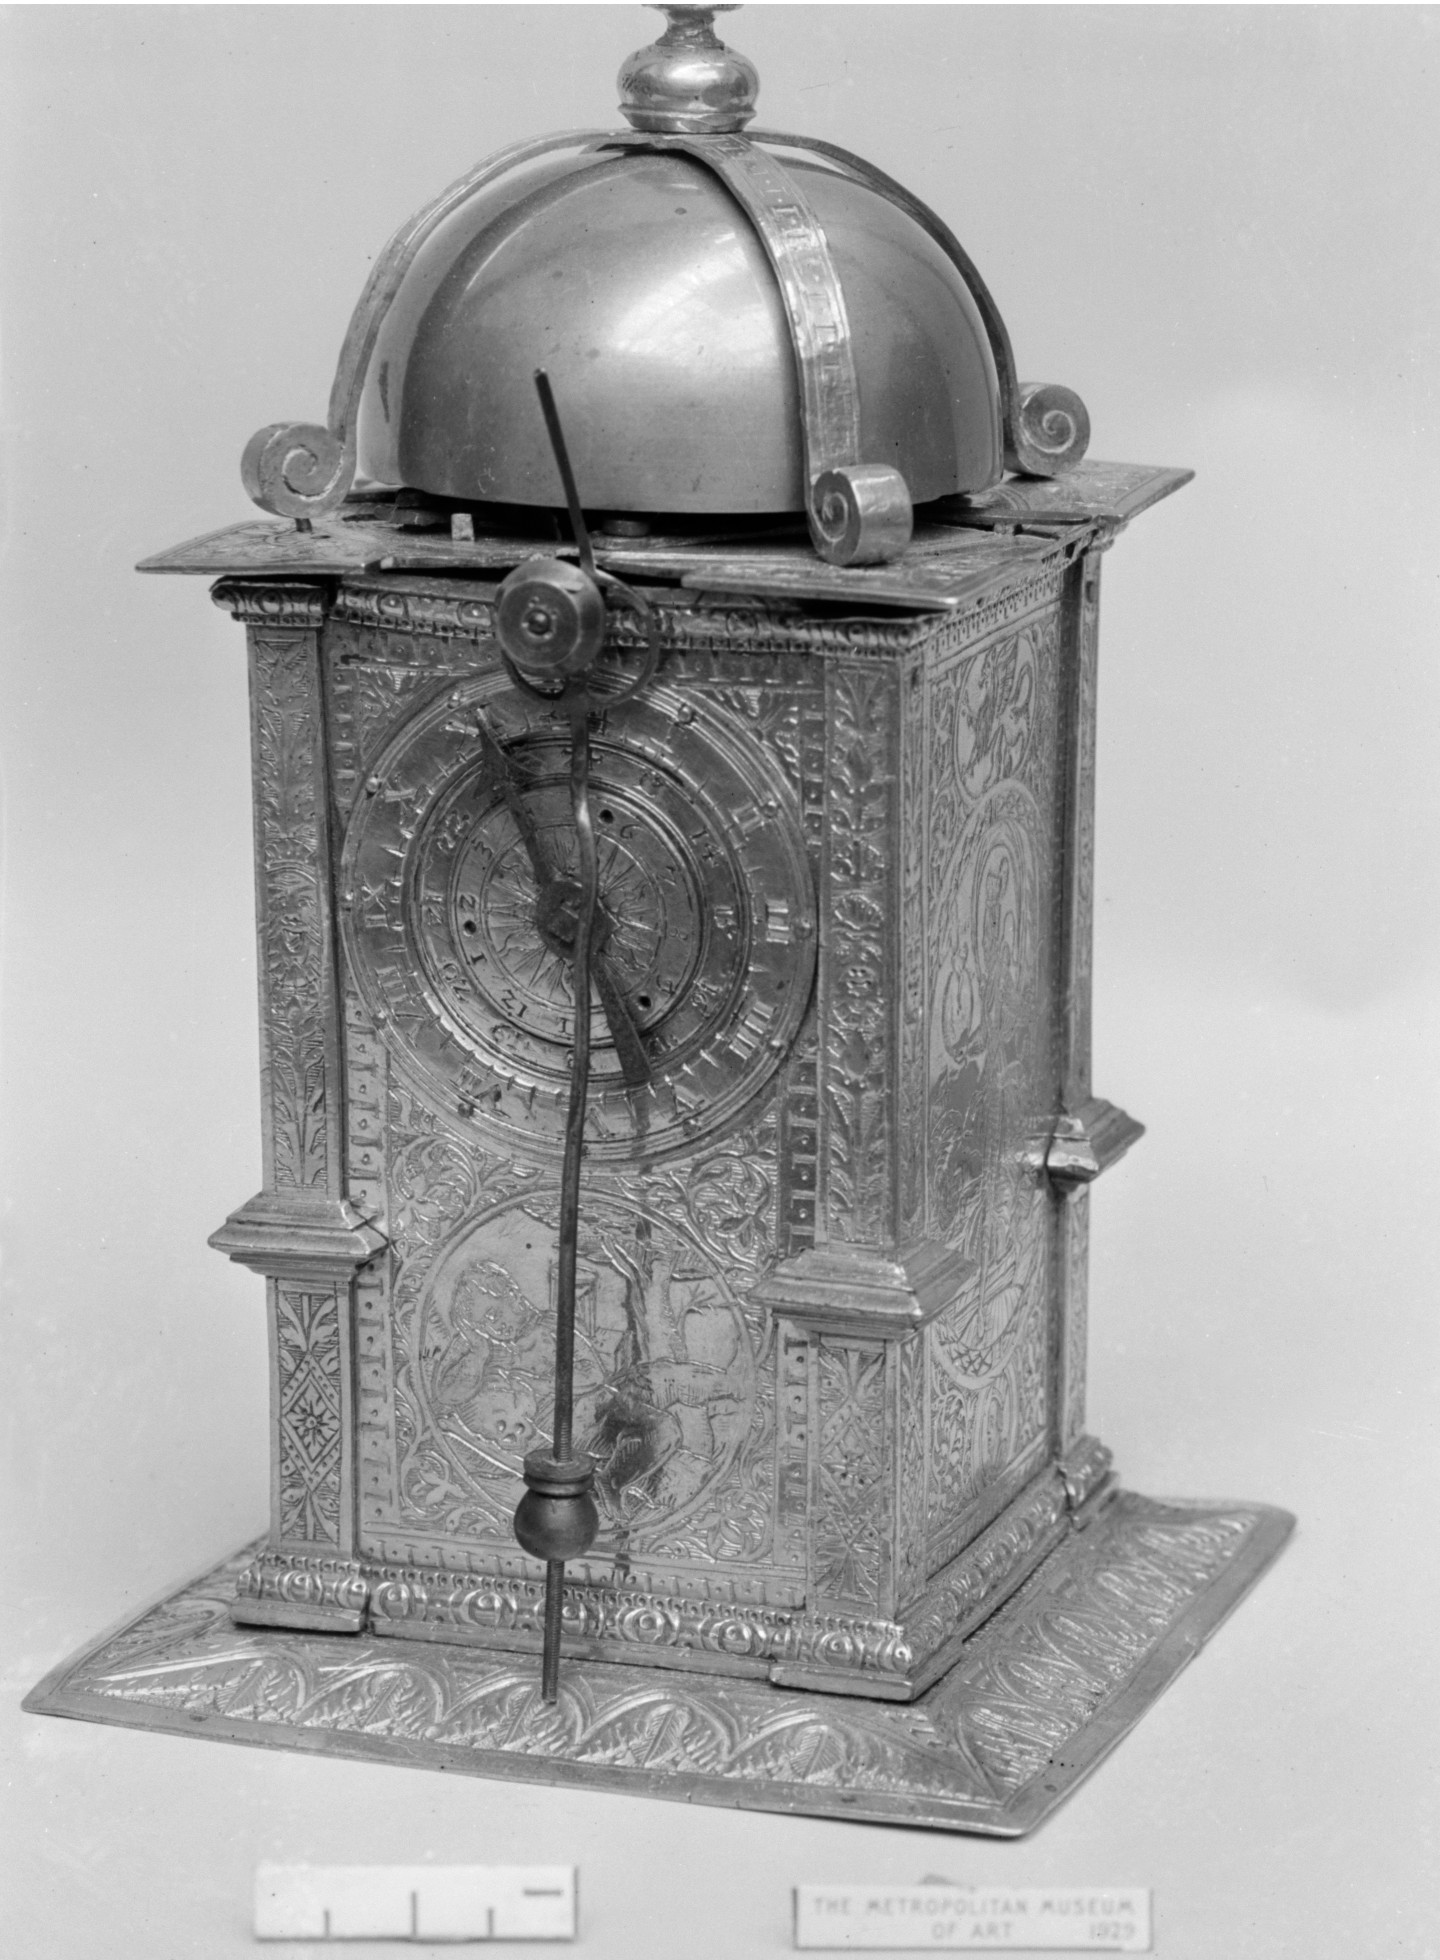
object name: clock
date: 1567-1600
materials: brass, gilt